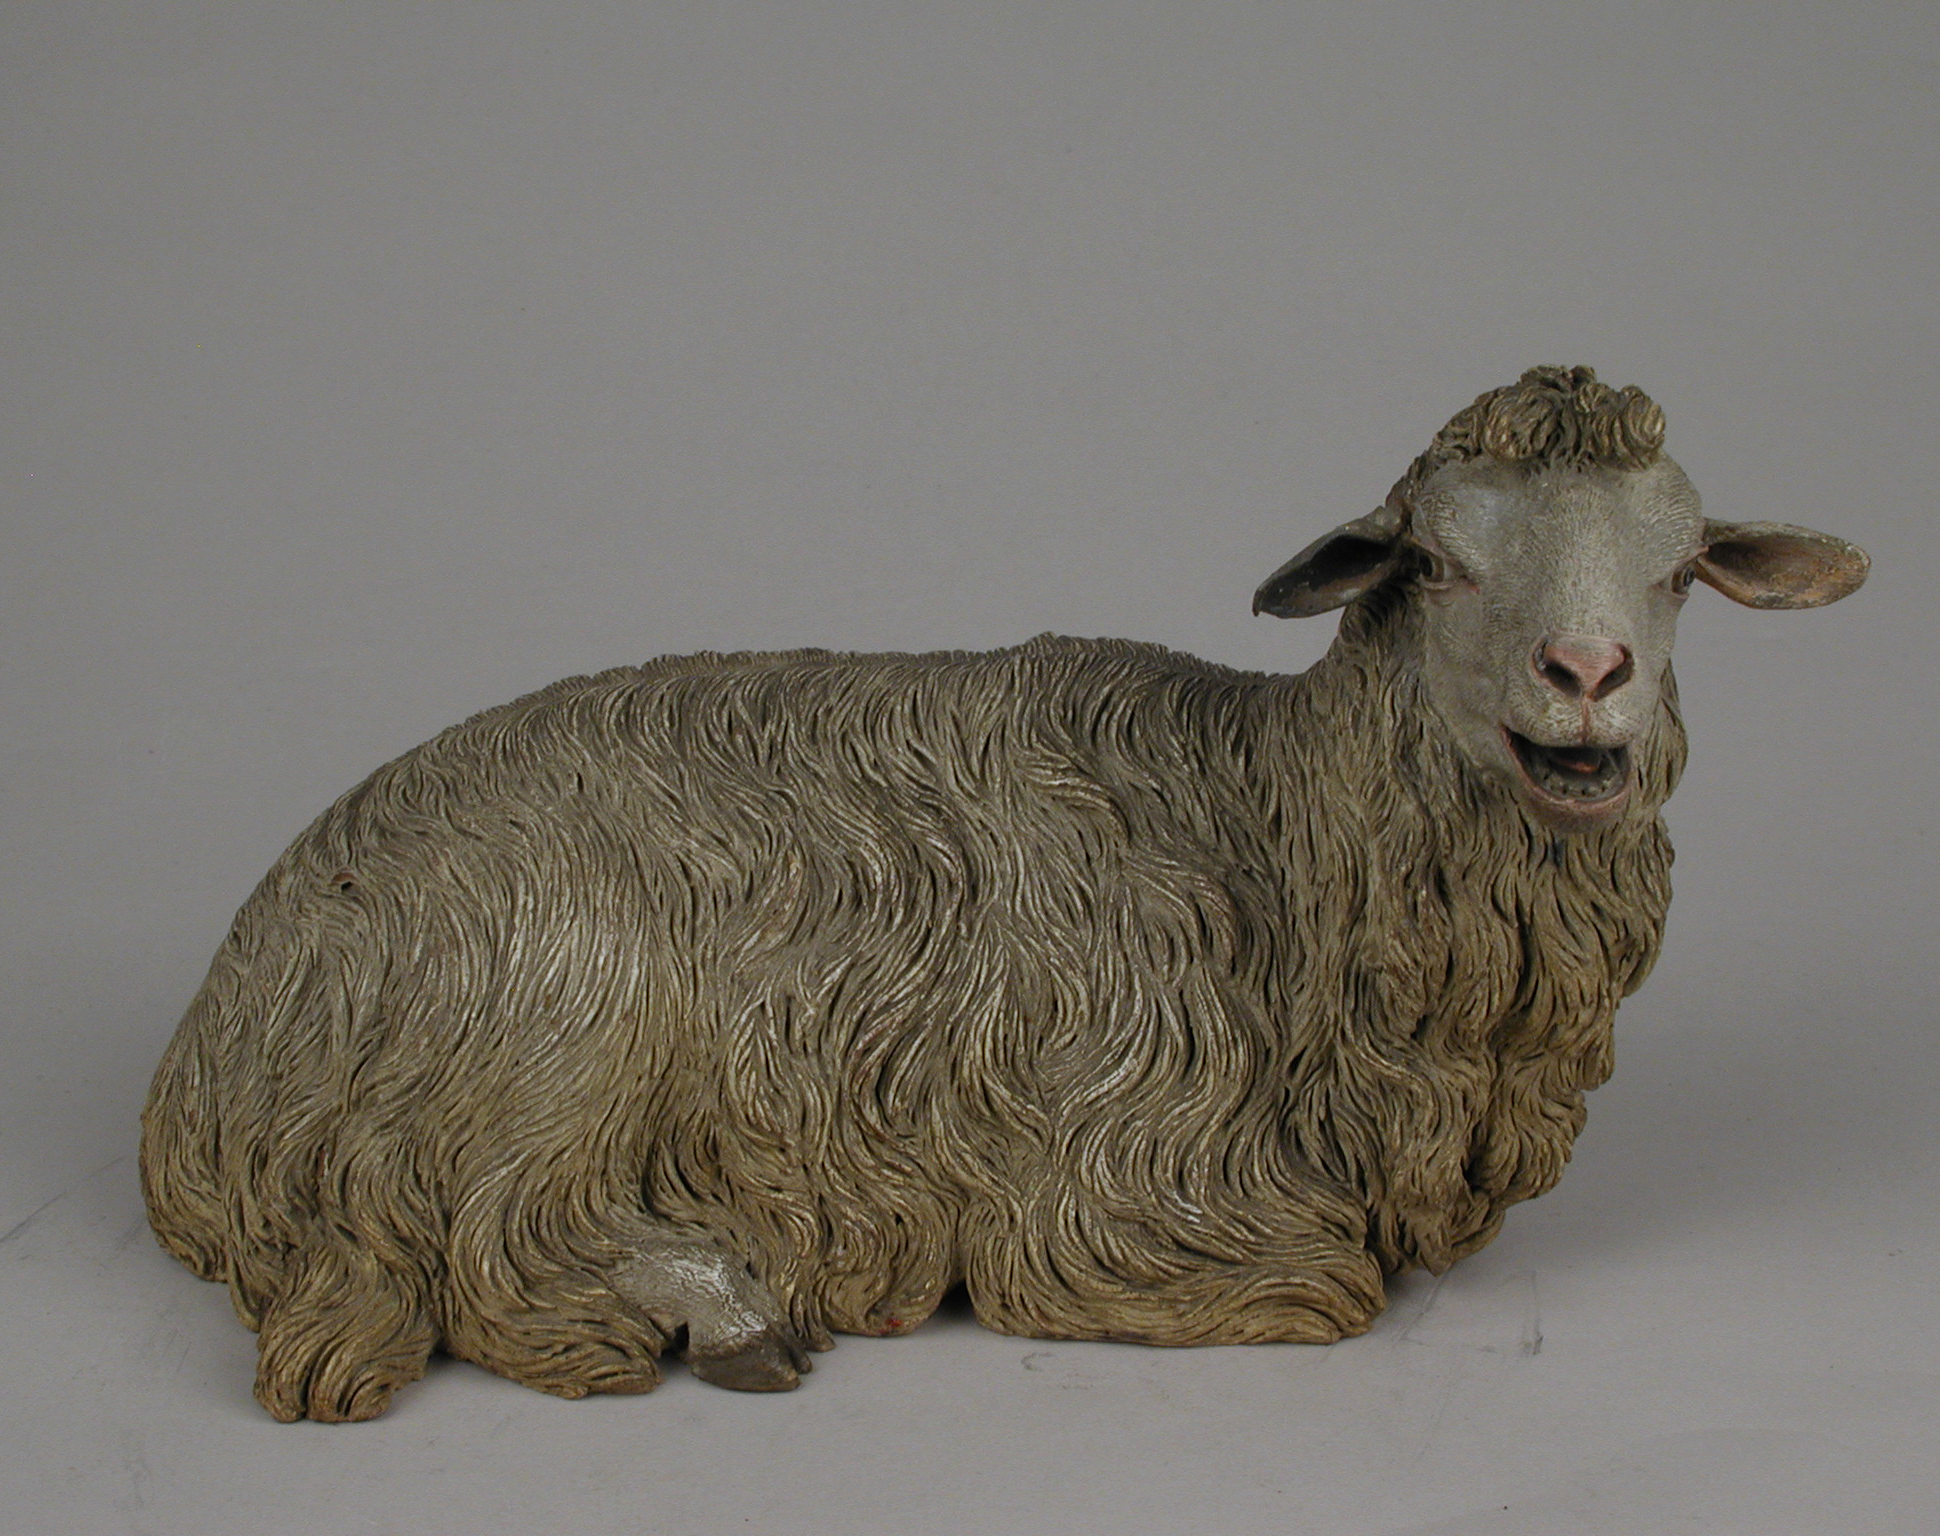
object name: crèche figure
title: Seated sheep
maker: francesco gallo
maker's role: maker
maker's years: 1700-1800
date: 1701-1900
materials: metal, terracotta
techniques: polychrome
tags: sheep